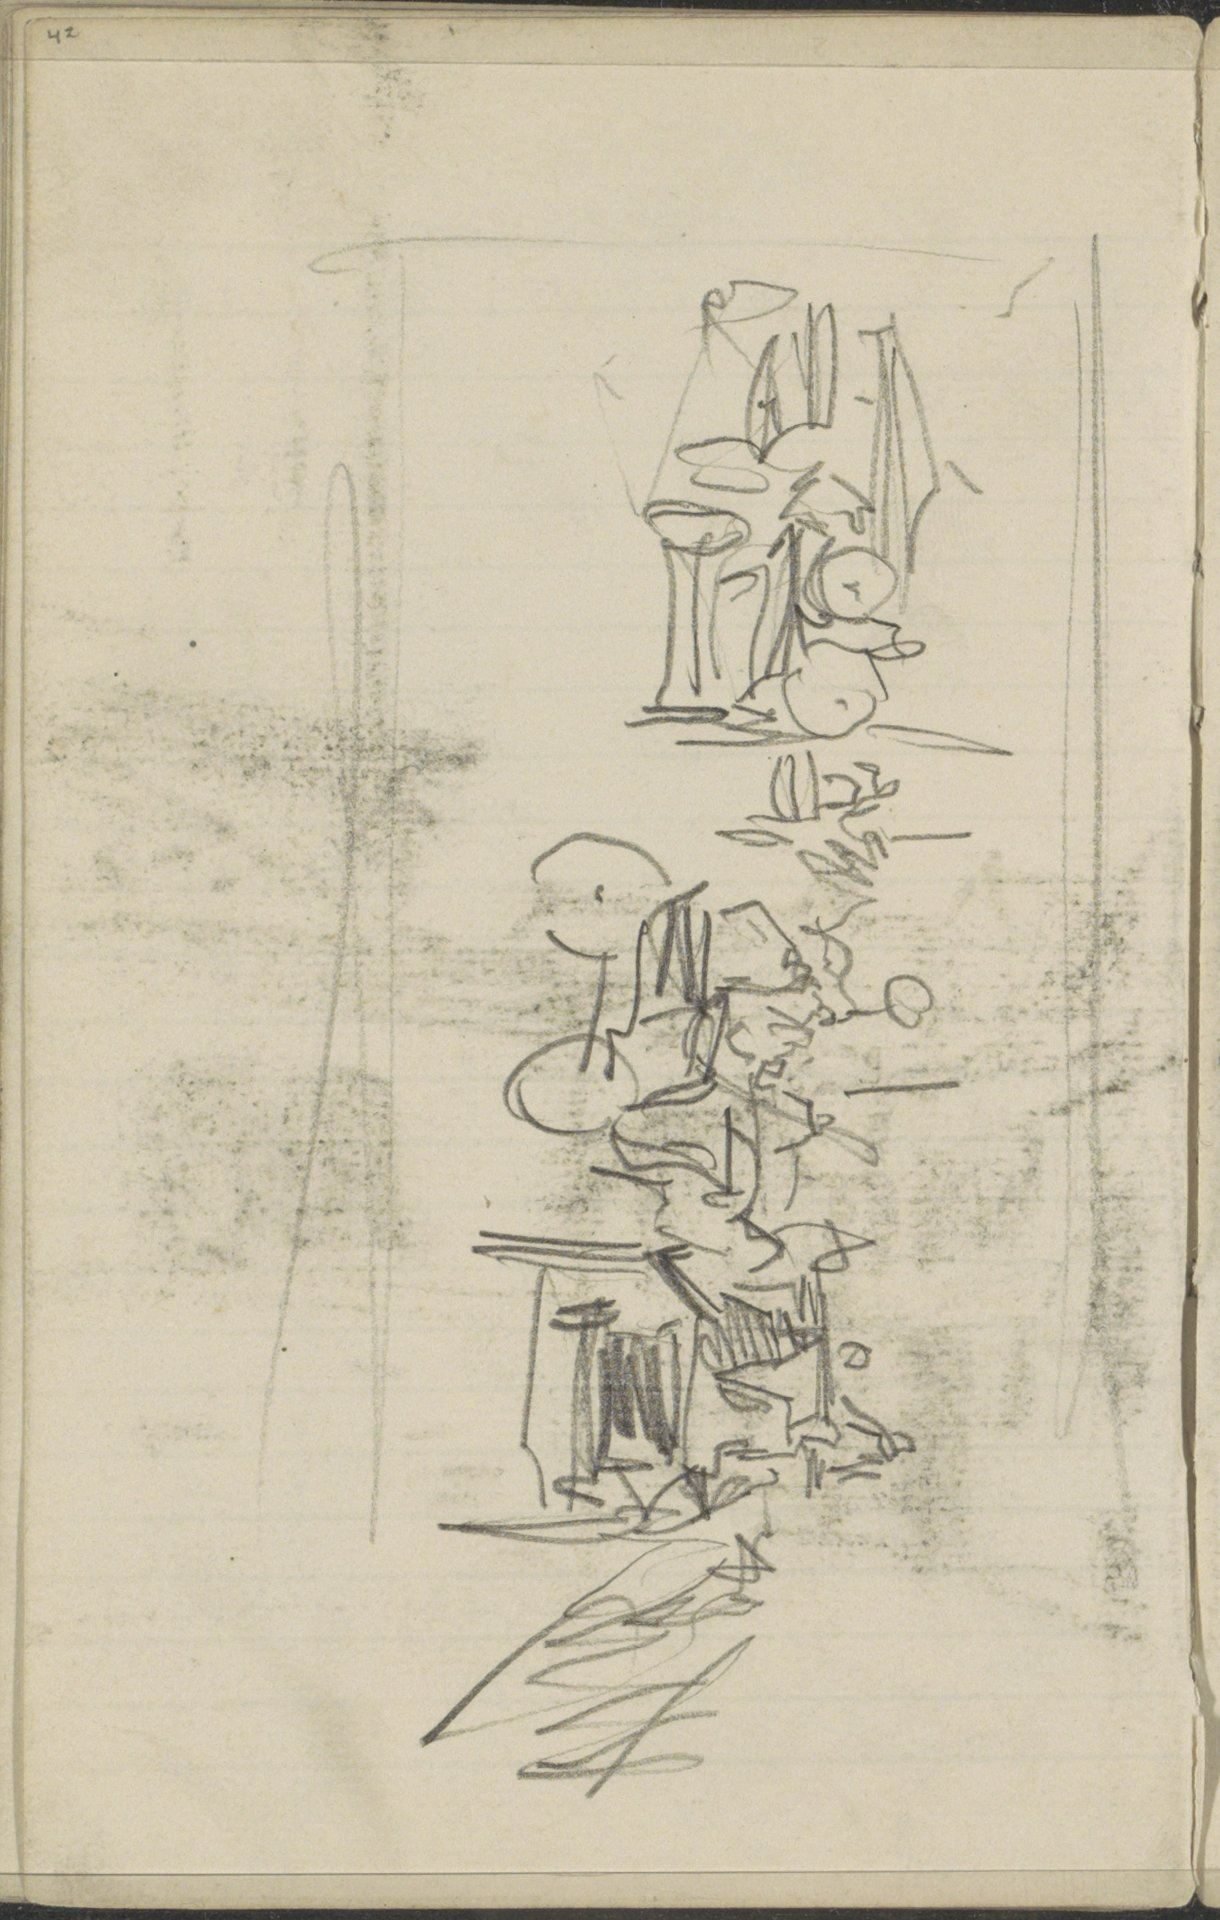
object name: sketchbook leaf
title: Weg met figuren op een koets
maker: marius bauer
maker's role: draughtsman, print maker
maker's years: 1867-1932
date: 1881-1885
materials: pencil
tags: four-wheeled, animal-drawn vehicle, e.g.: cab, carriage, coach, street (+ city(-scape) with figures, staffage)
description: Tevens andere figuren op en in verschillende vervoersmiddelen. Pagina 42 uit een schetsboek met 26 bladen.